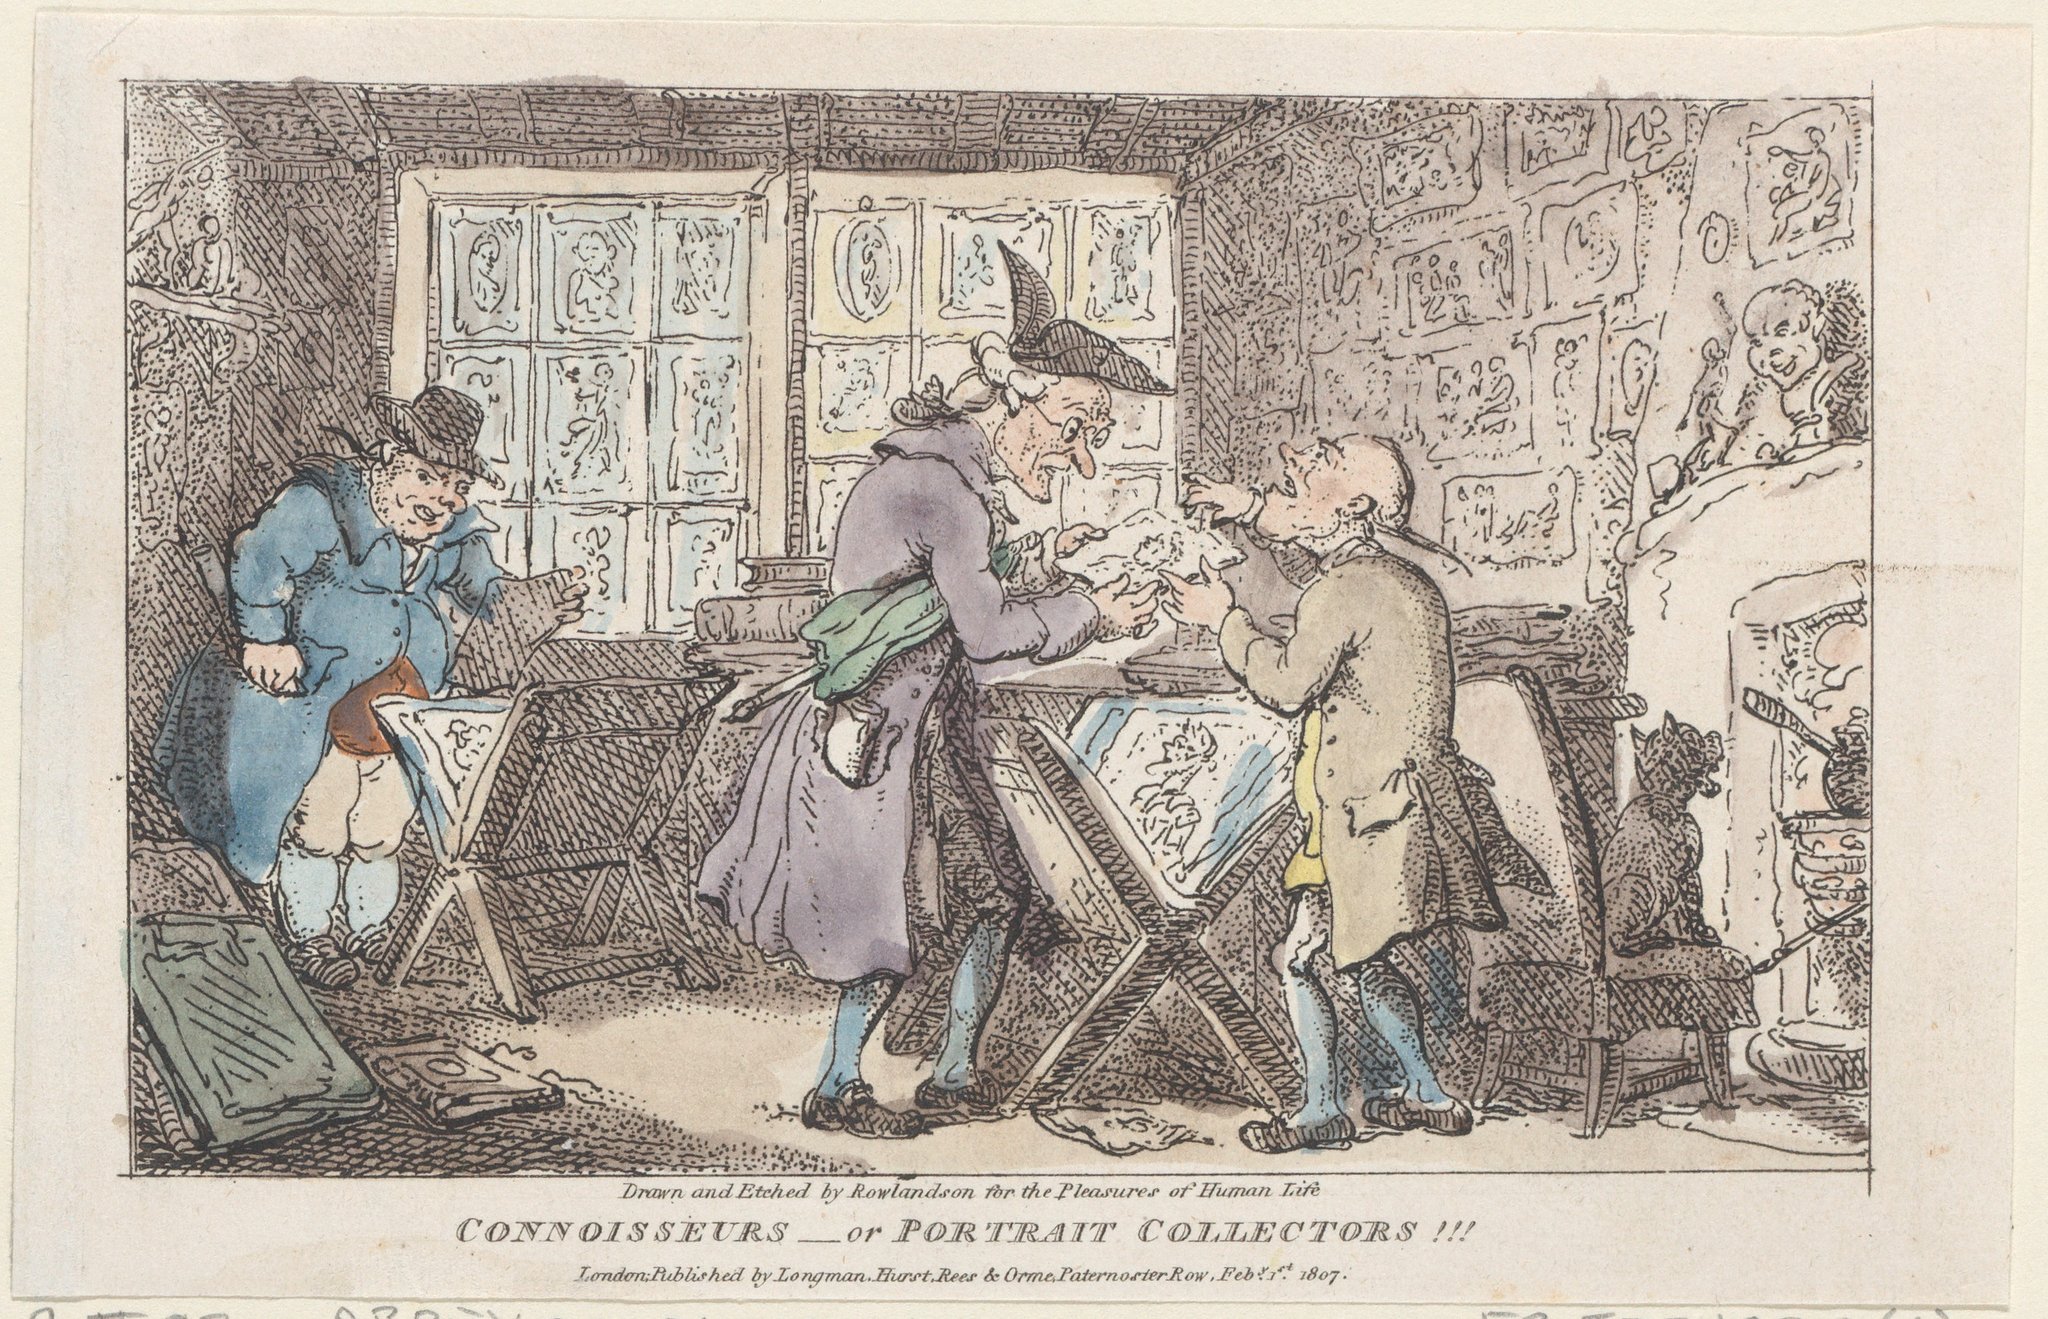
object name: print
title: Connoisseurs–or Portrait Collectors !!!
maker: thomas rowlandson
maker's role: artist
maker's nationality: british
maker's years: 1757-1827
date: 1807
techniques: etching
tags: satire,men